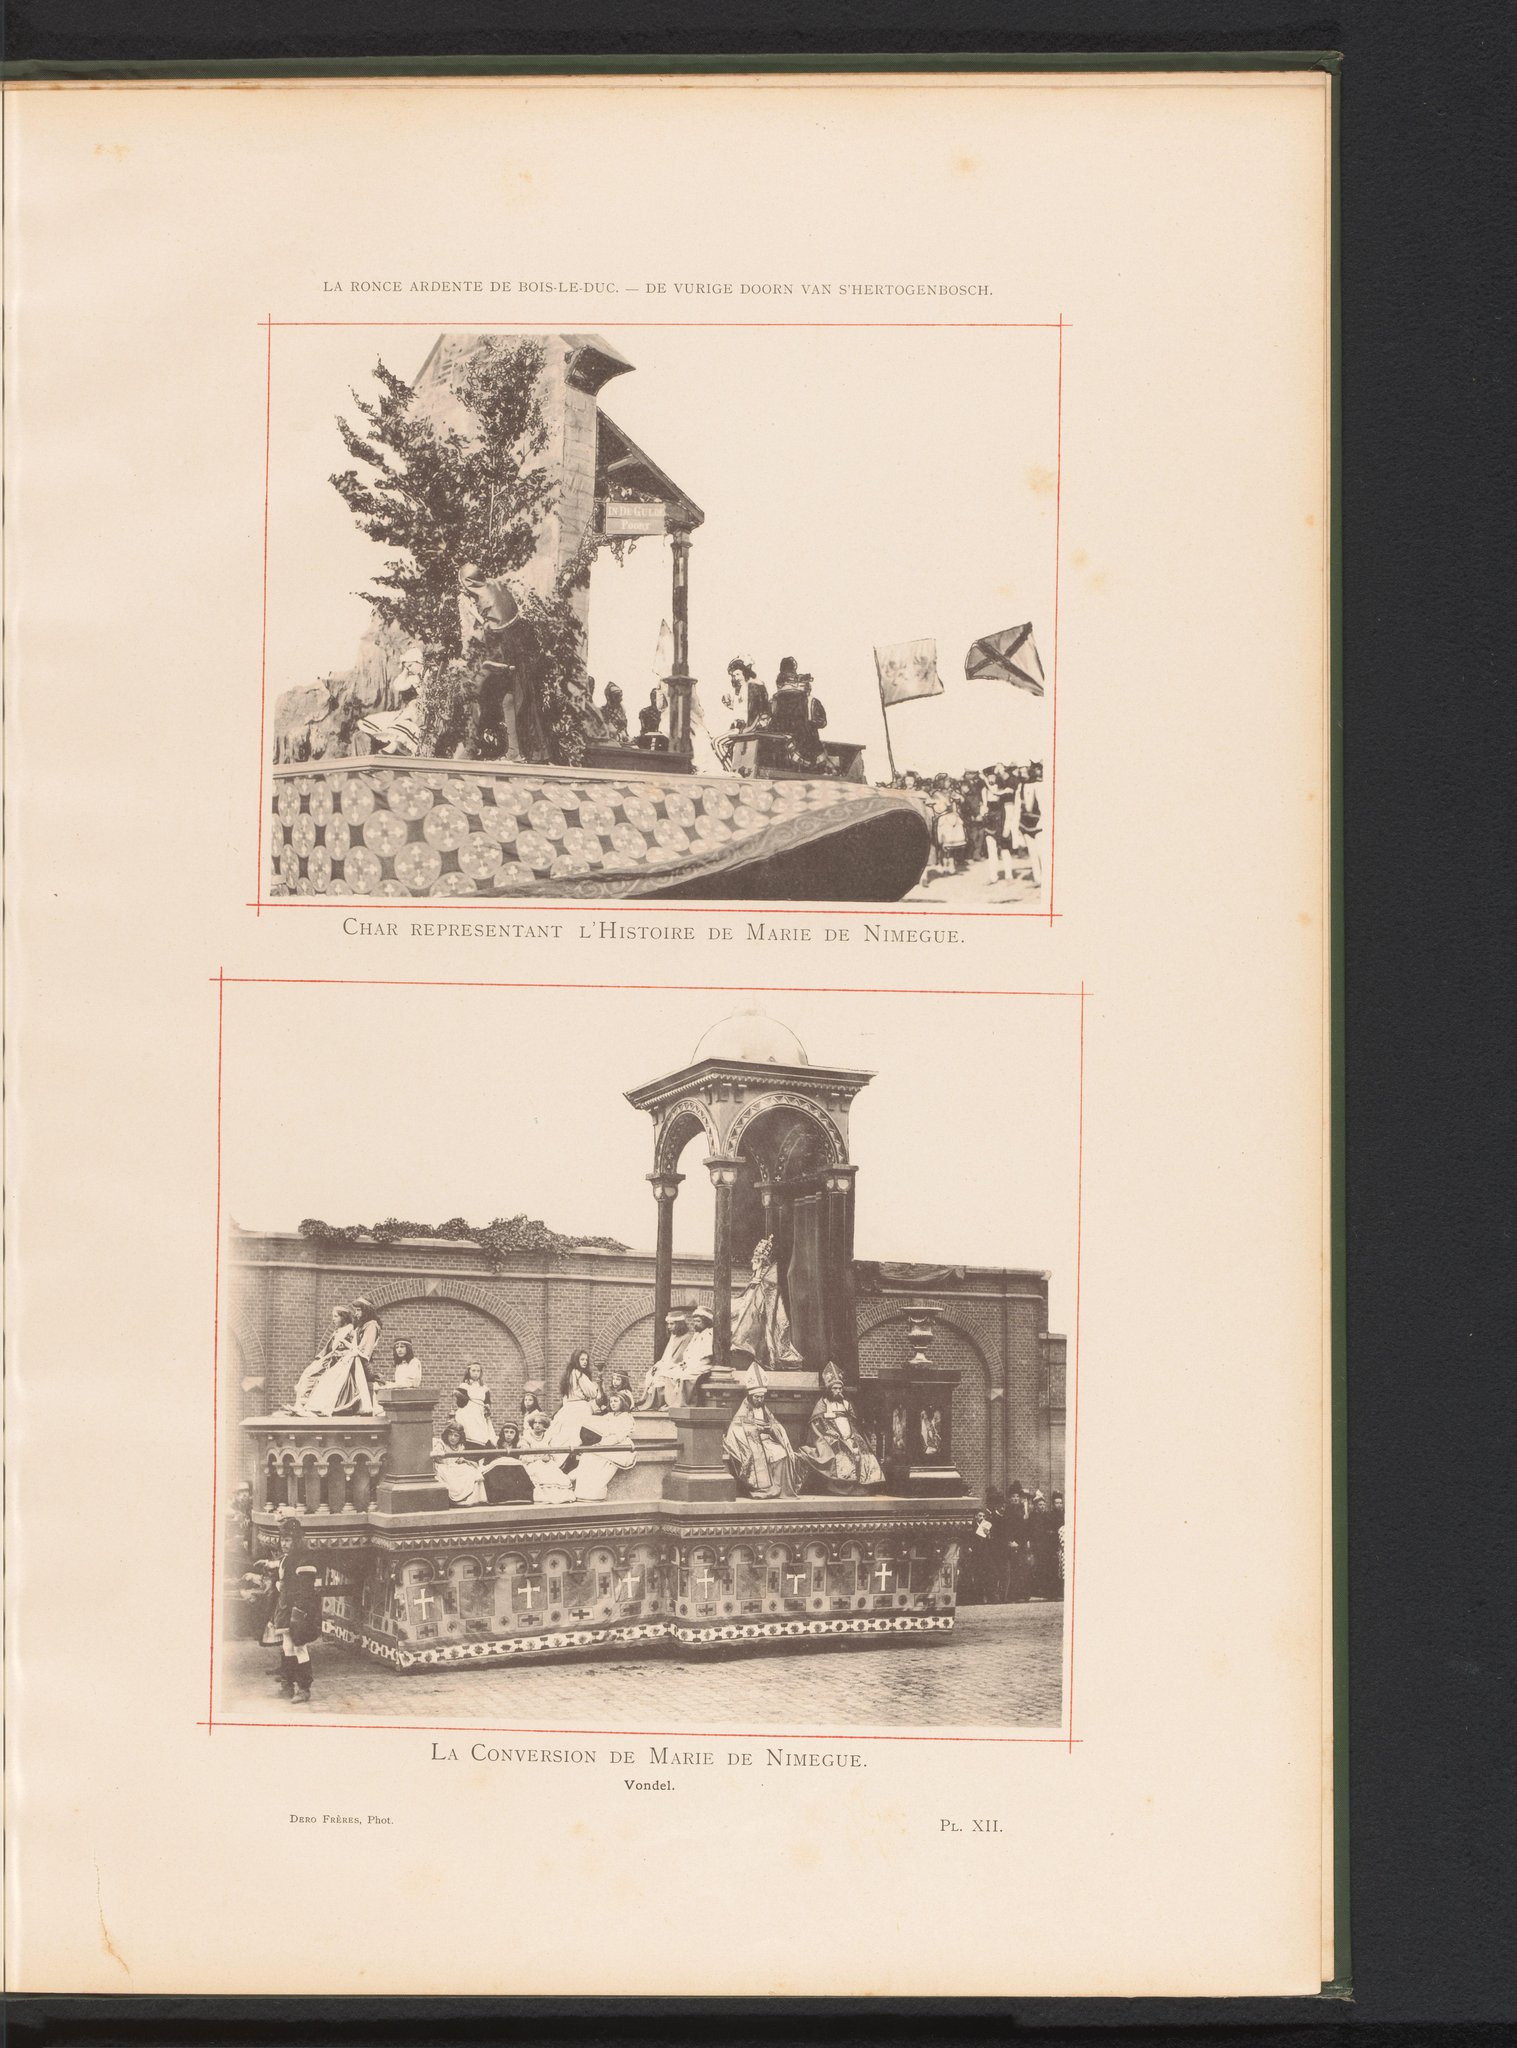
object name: photomechanical print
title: La Conversion de Marie de Nimegue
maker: joseph maes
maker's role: fotograaf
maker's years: 1838-1908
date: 1892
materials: paper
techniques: photograph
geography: antwerp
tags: public festivities (+ parade, pageant, cavalcade ~ festive activities), antwerp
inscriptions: inscription: ‘LA RONCE ARDENTE DE BOIS-LE-DUC. - DE VURIGE DOORN VAN S'HERTOGENBOSCH.’, inscription: ‘Vondel.’, number: ‘Pl. XII.’